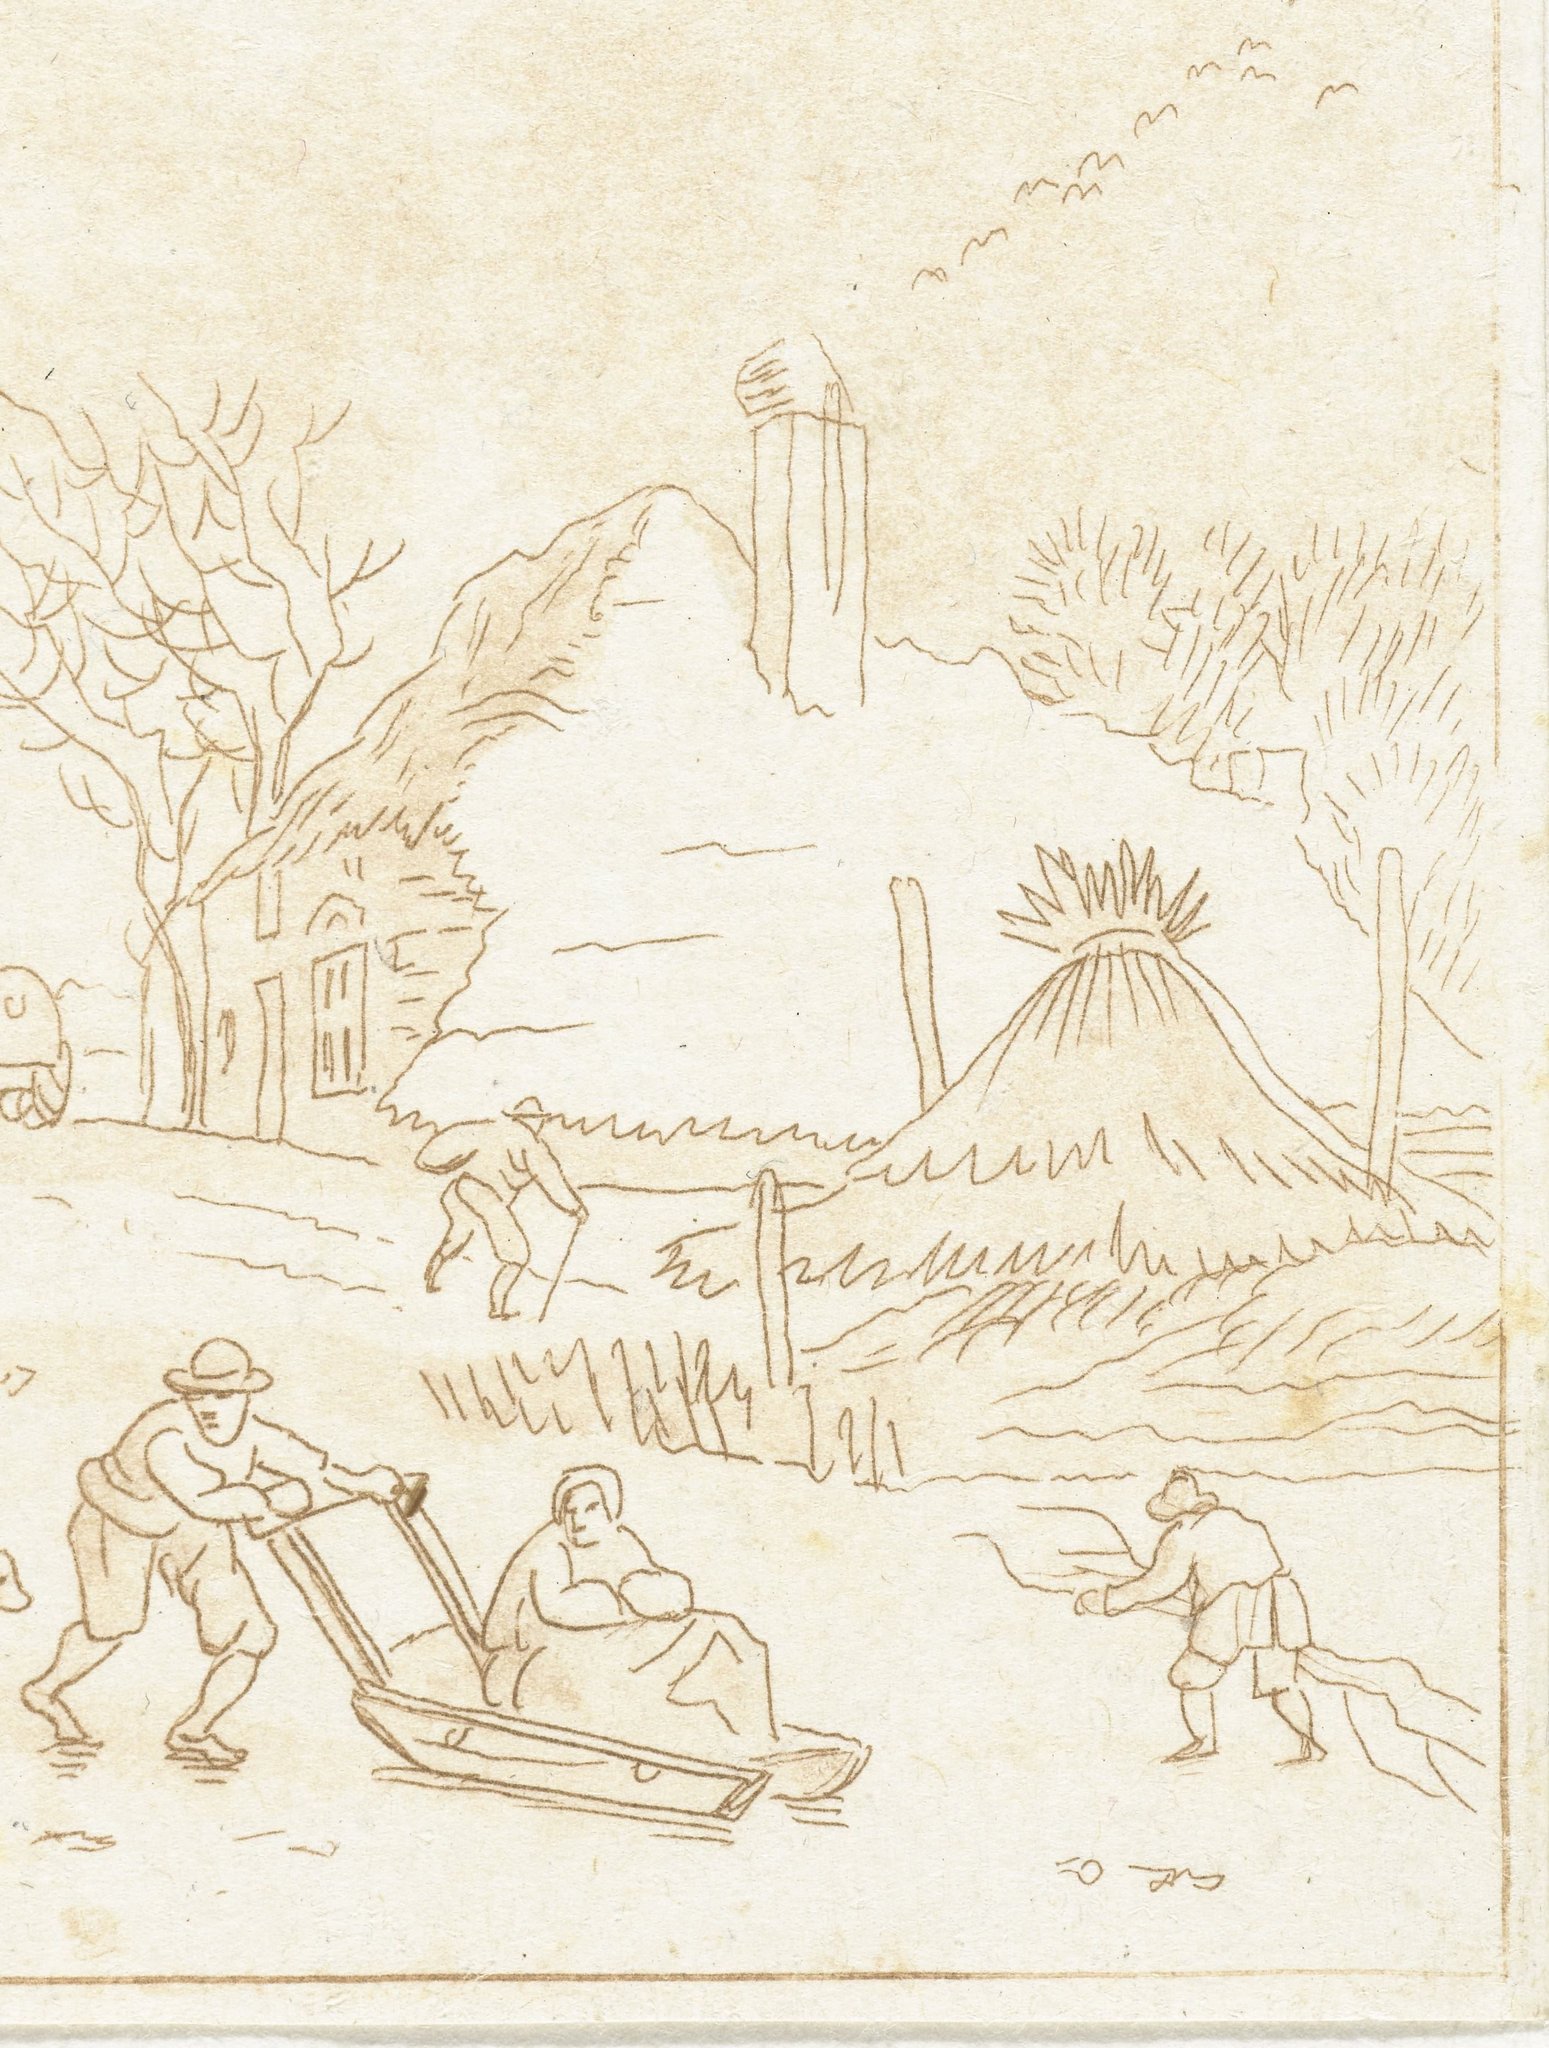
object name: print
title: Winterlandschap met ijsvermaak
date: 1778-1838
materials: paper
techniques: printmaking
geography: netherlands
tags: winter sports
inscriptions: collector's mark: Lugt 2228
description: Winterlandschap. Op een bevroren rivier duwt een boer een slede met een vrouw. Achter hem aan loopt een hond. Rechts loopt een jongen die takken vergaart heeft. Op de achtergrond een huis met een kar ervoor.